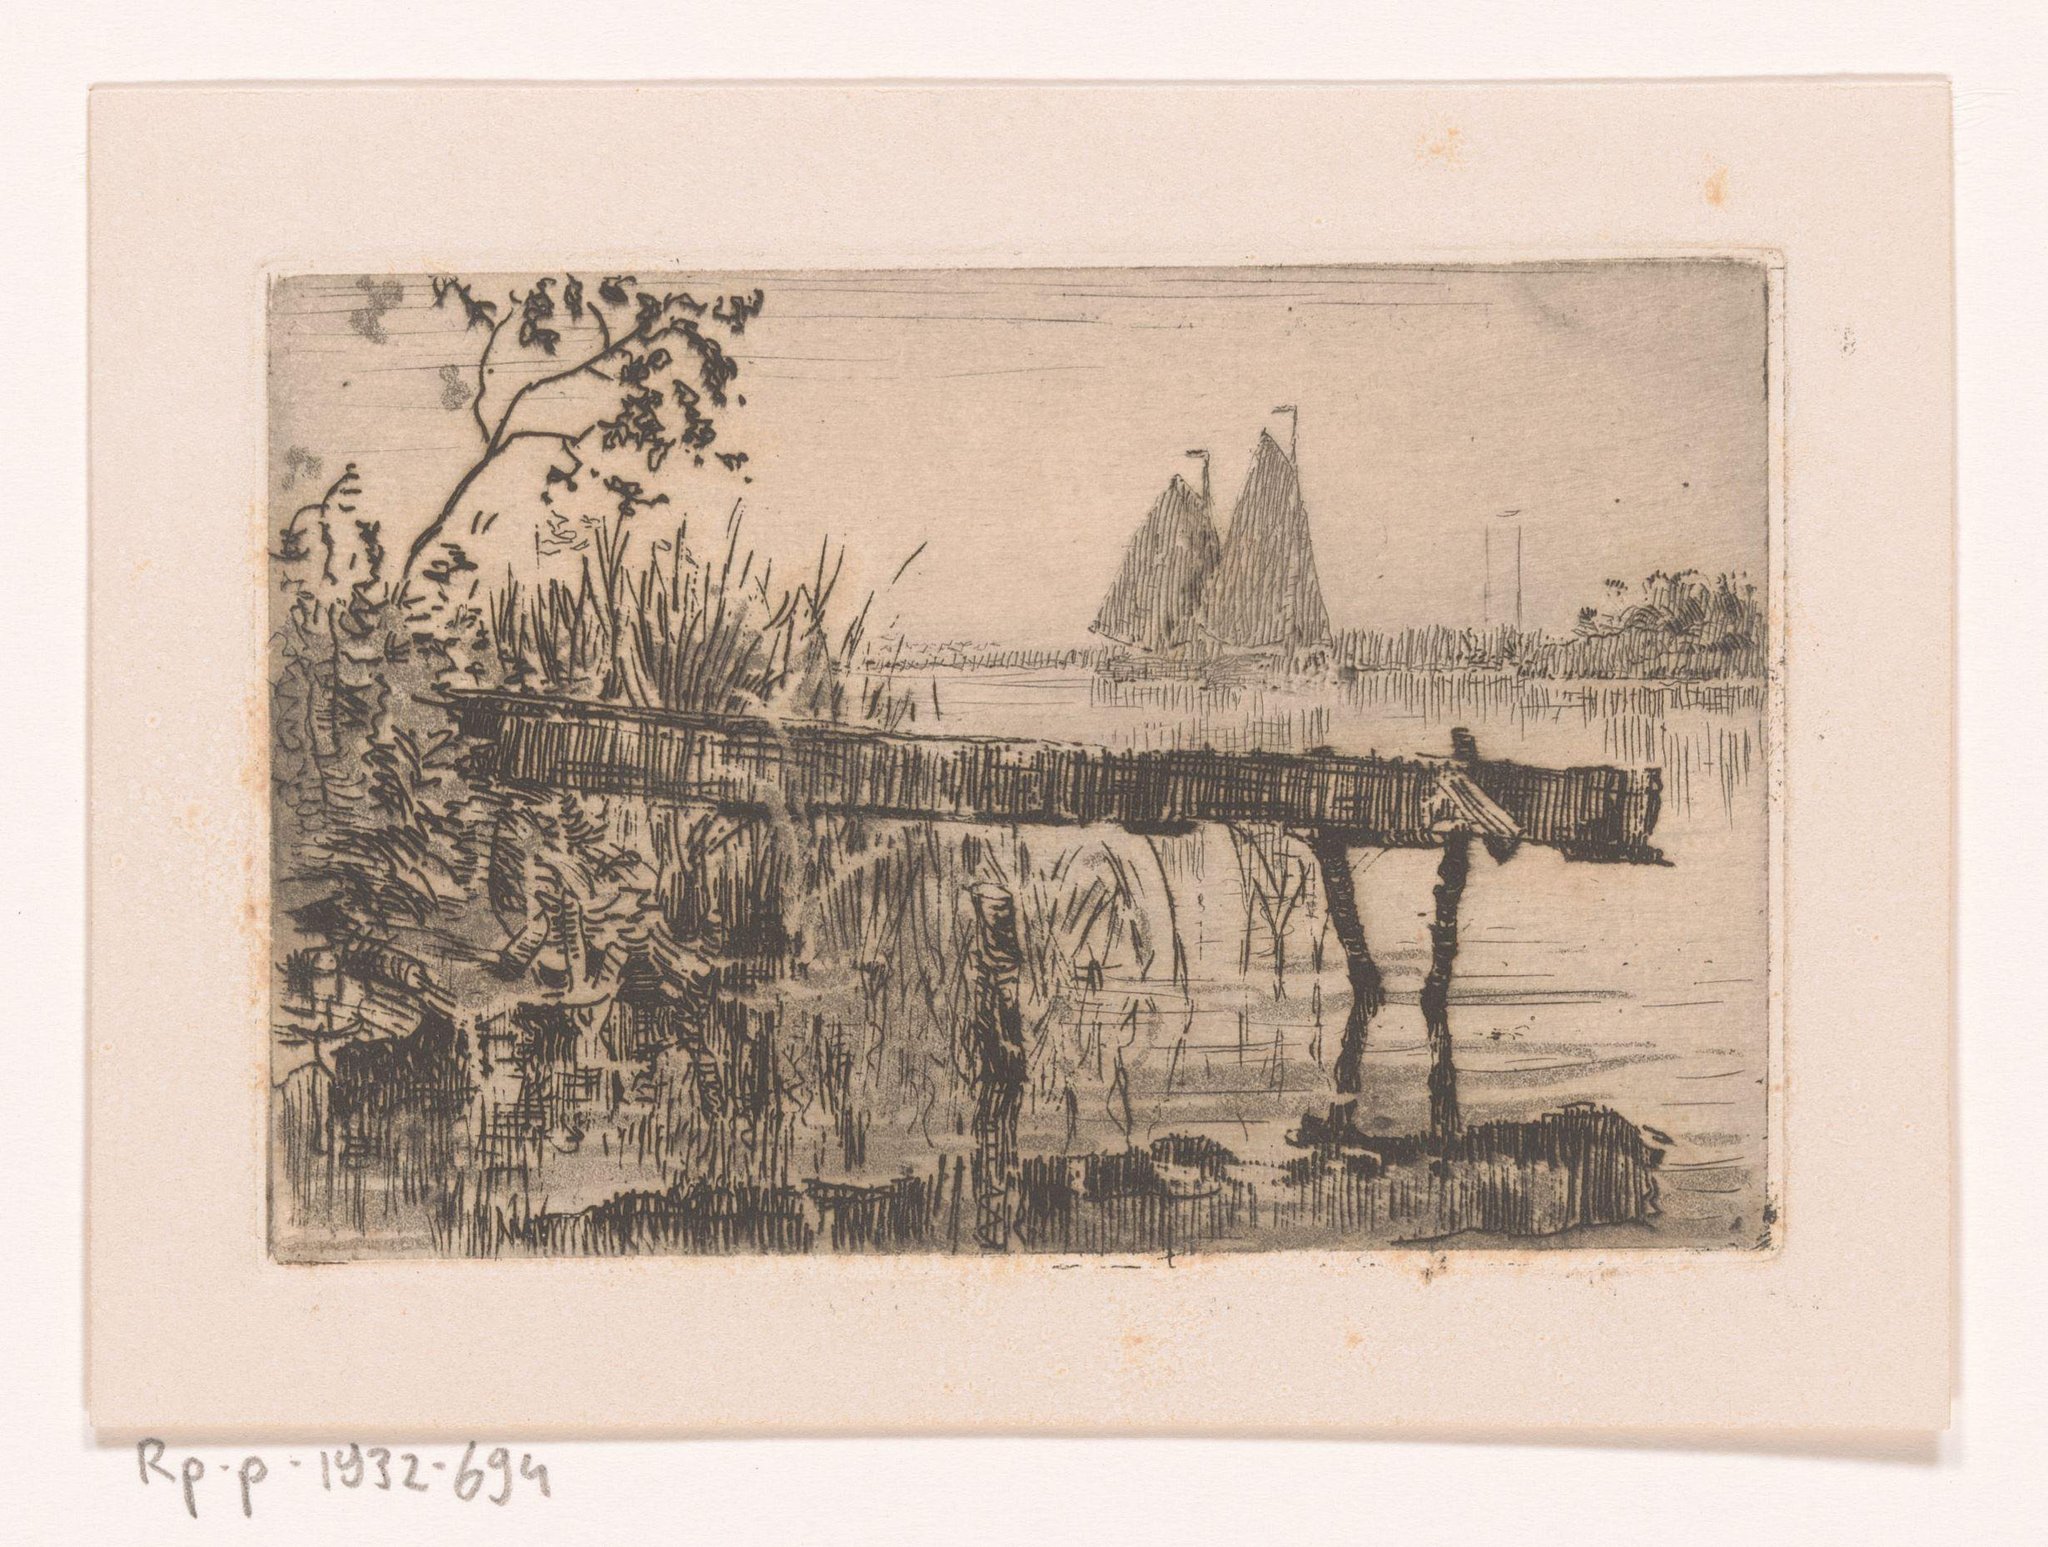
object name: print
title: Donker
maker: willem bastiaan tholen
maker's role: draughtsman, painter, print maker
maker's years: 1860-1931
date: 1870-1914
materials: paper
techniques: aquatint, etching, intaglio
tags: sailing-ship, sailing-boat, lake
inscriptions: collector's mark: Lugt 2228